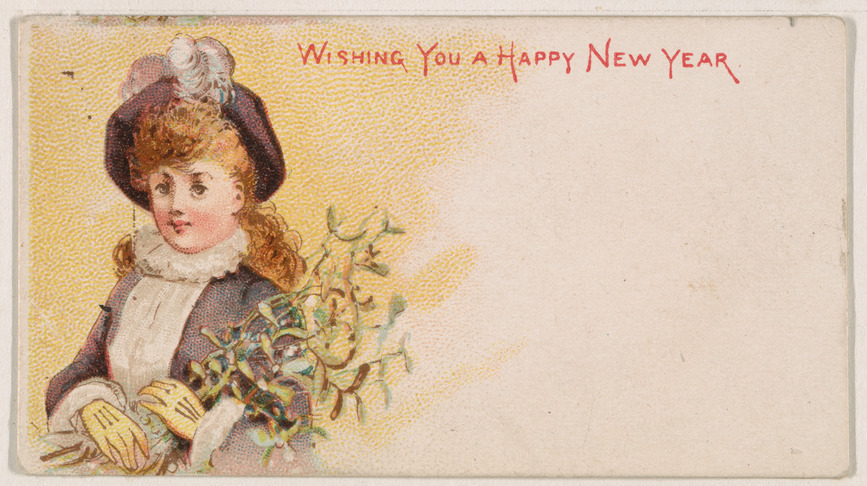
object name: print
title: Wishing You a Happy New Year, from the New Years 1890 series (N227) issued by Kinney Bros.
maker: kinney brothers tobacco company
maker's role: publisher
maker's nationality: american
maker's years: 1869-2011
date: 1889-1890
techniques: color lithograph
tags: women